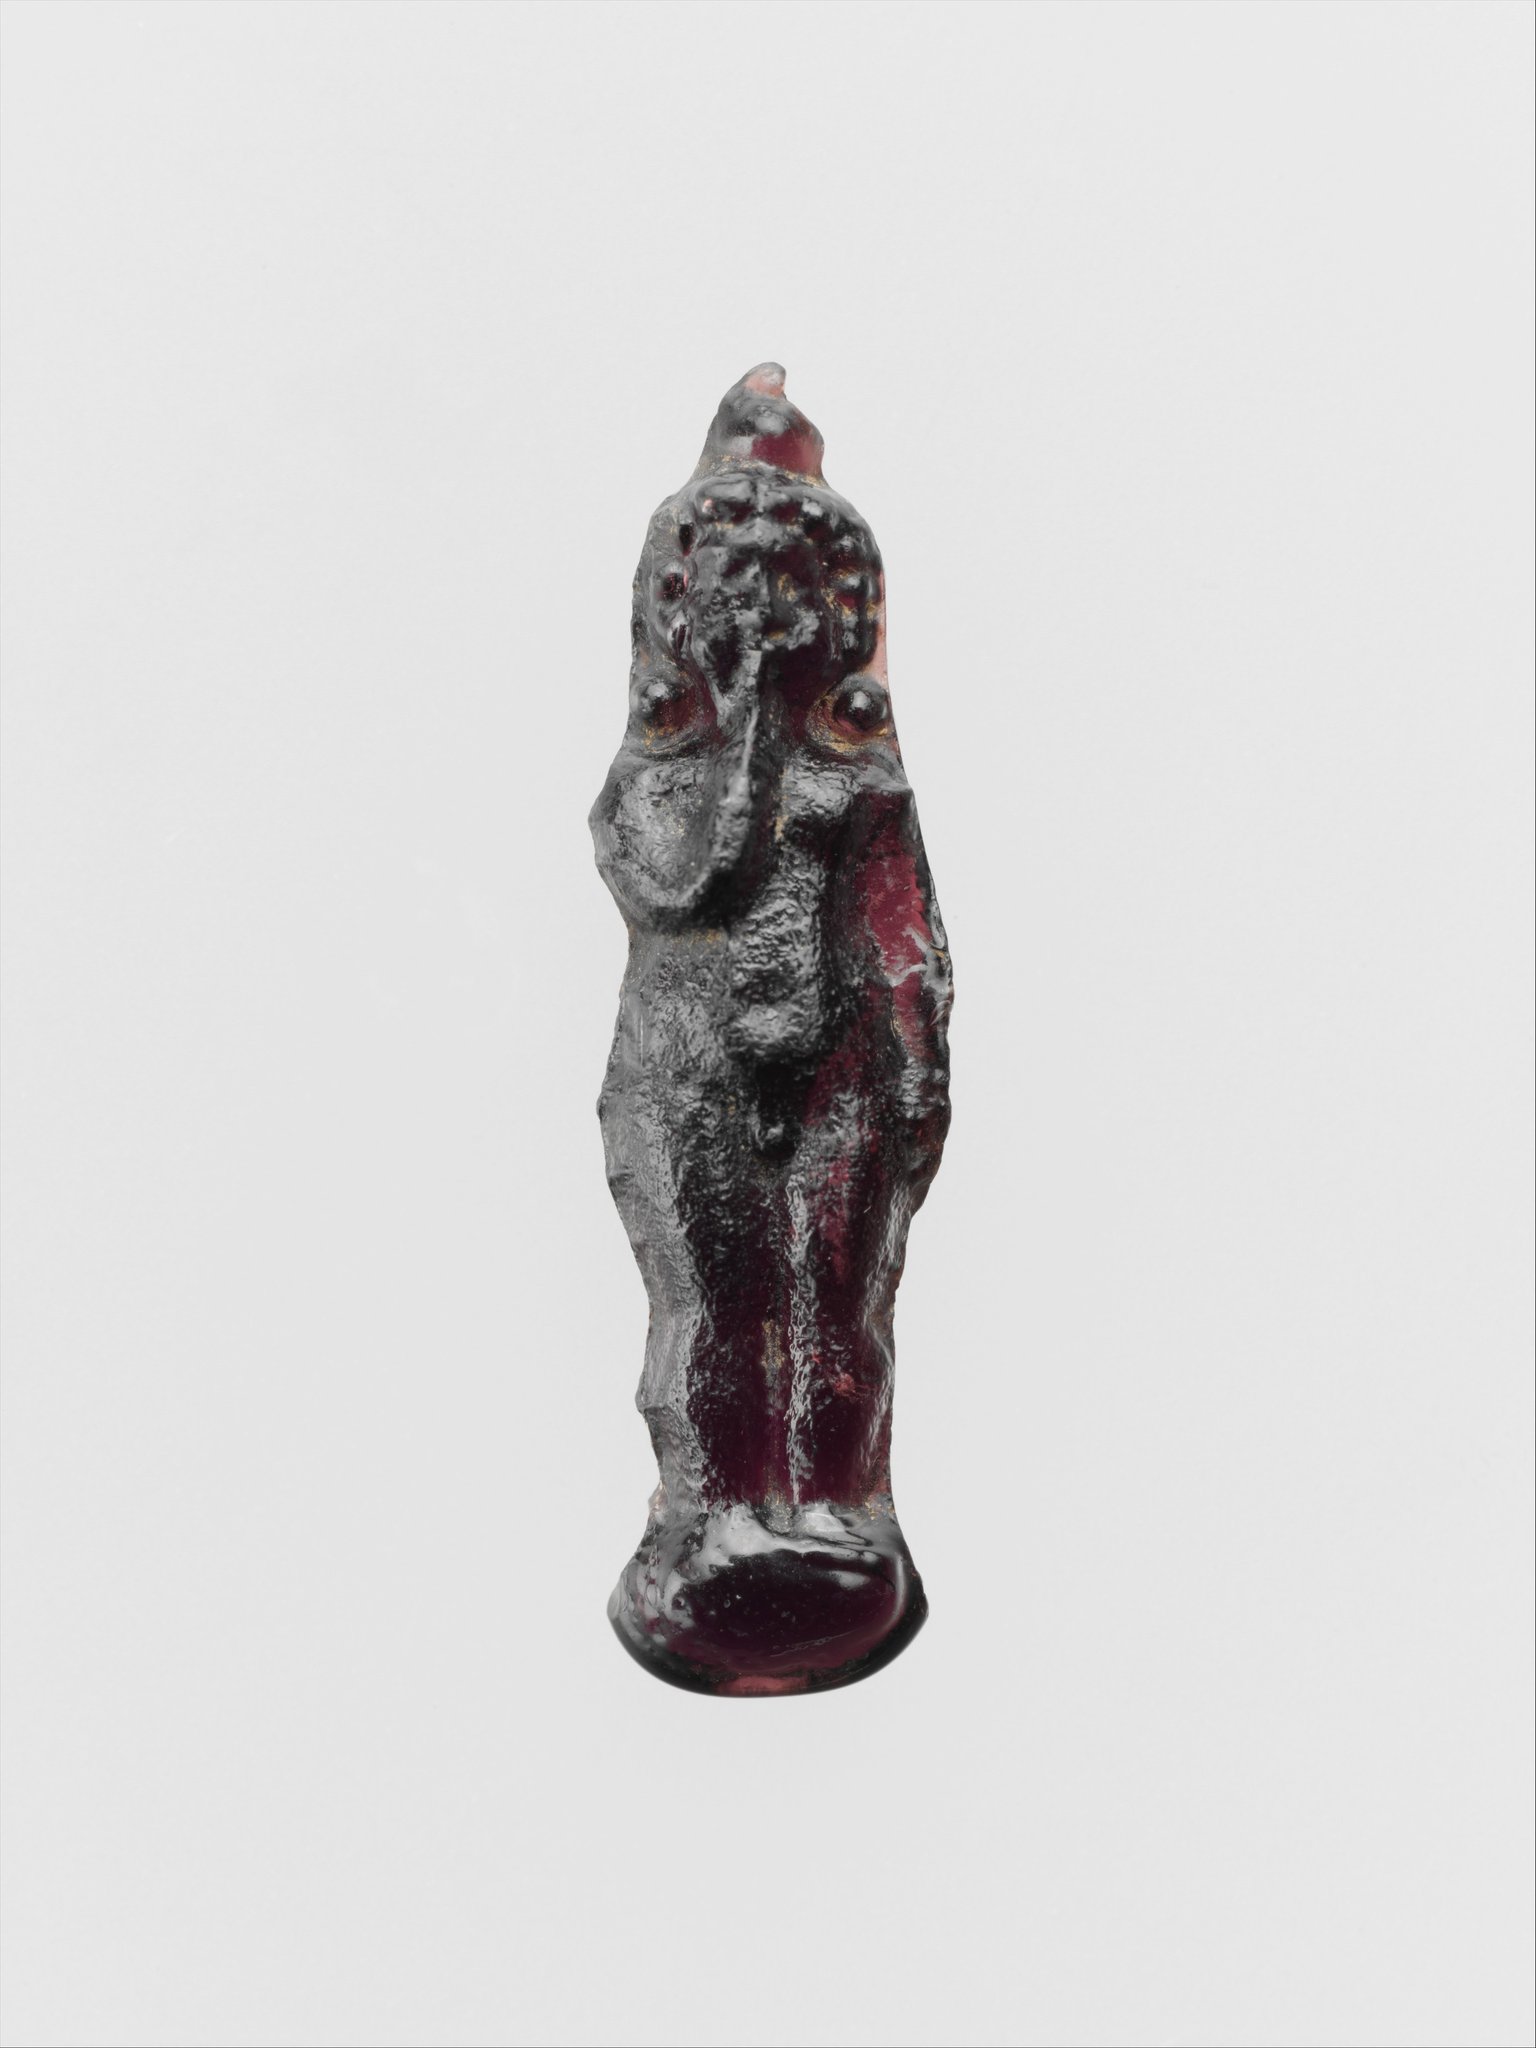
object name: pendant in the form of harpocrates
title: Glass pendant in the shape of Harpokrates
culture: greek, eastern mediterranean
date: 134-1 BCE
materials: glass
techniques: molding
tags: harpokrates